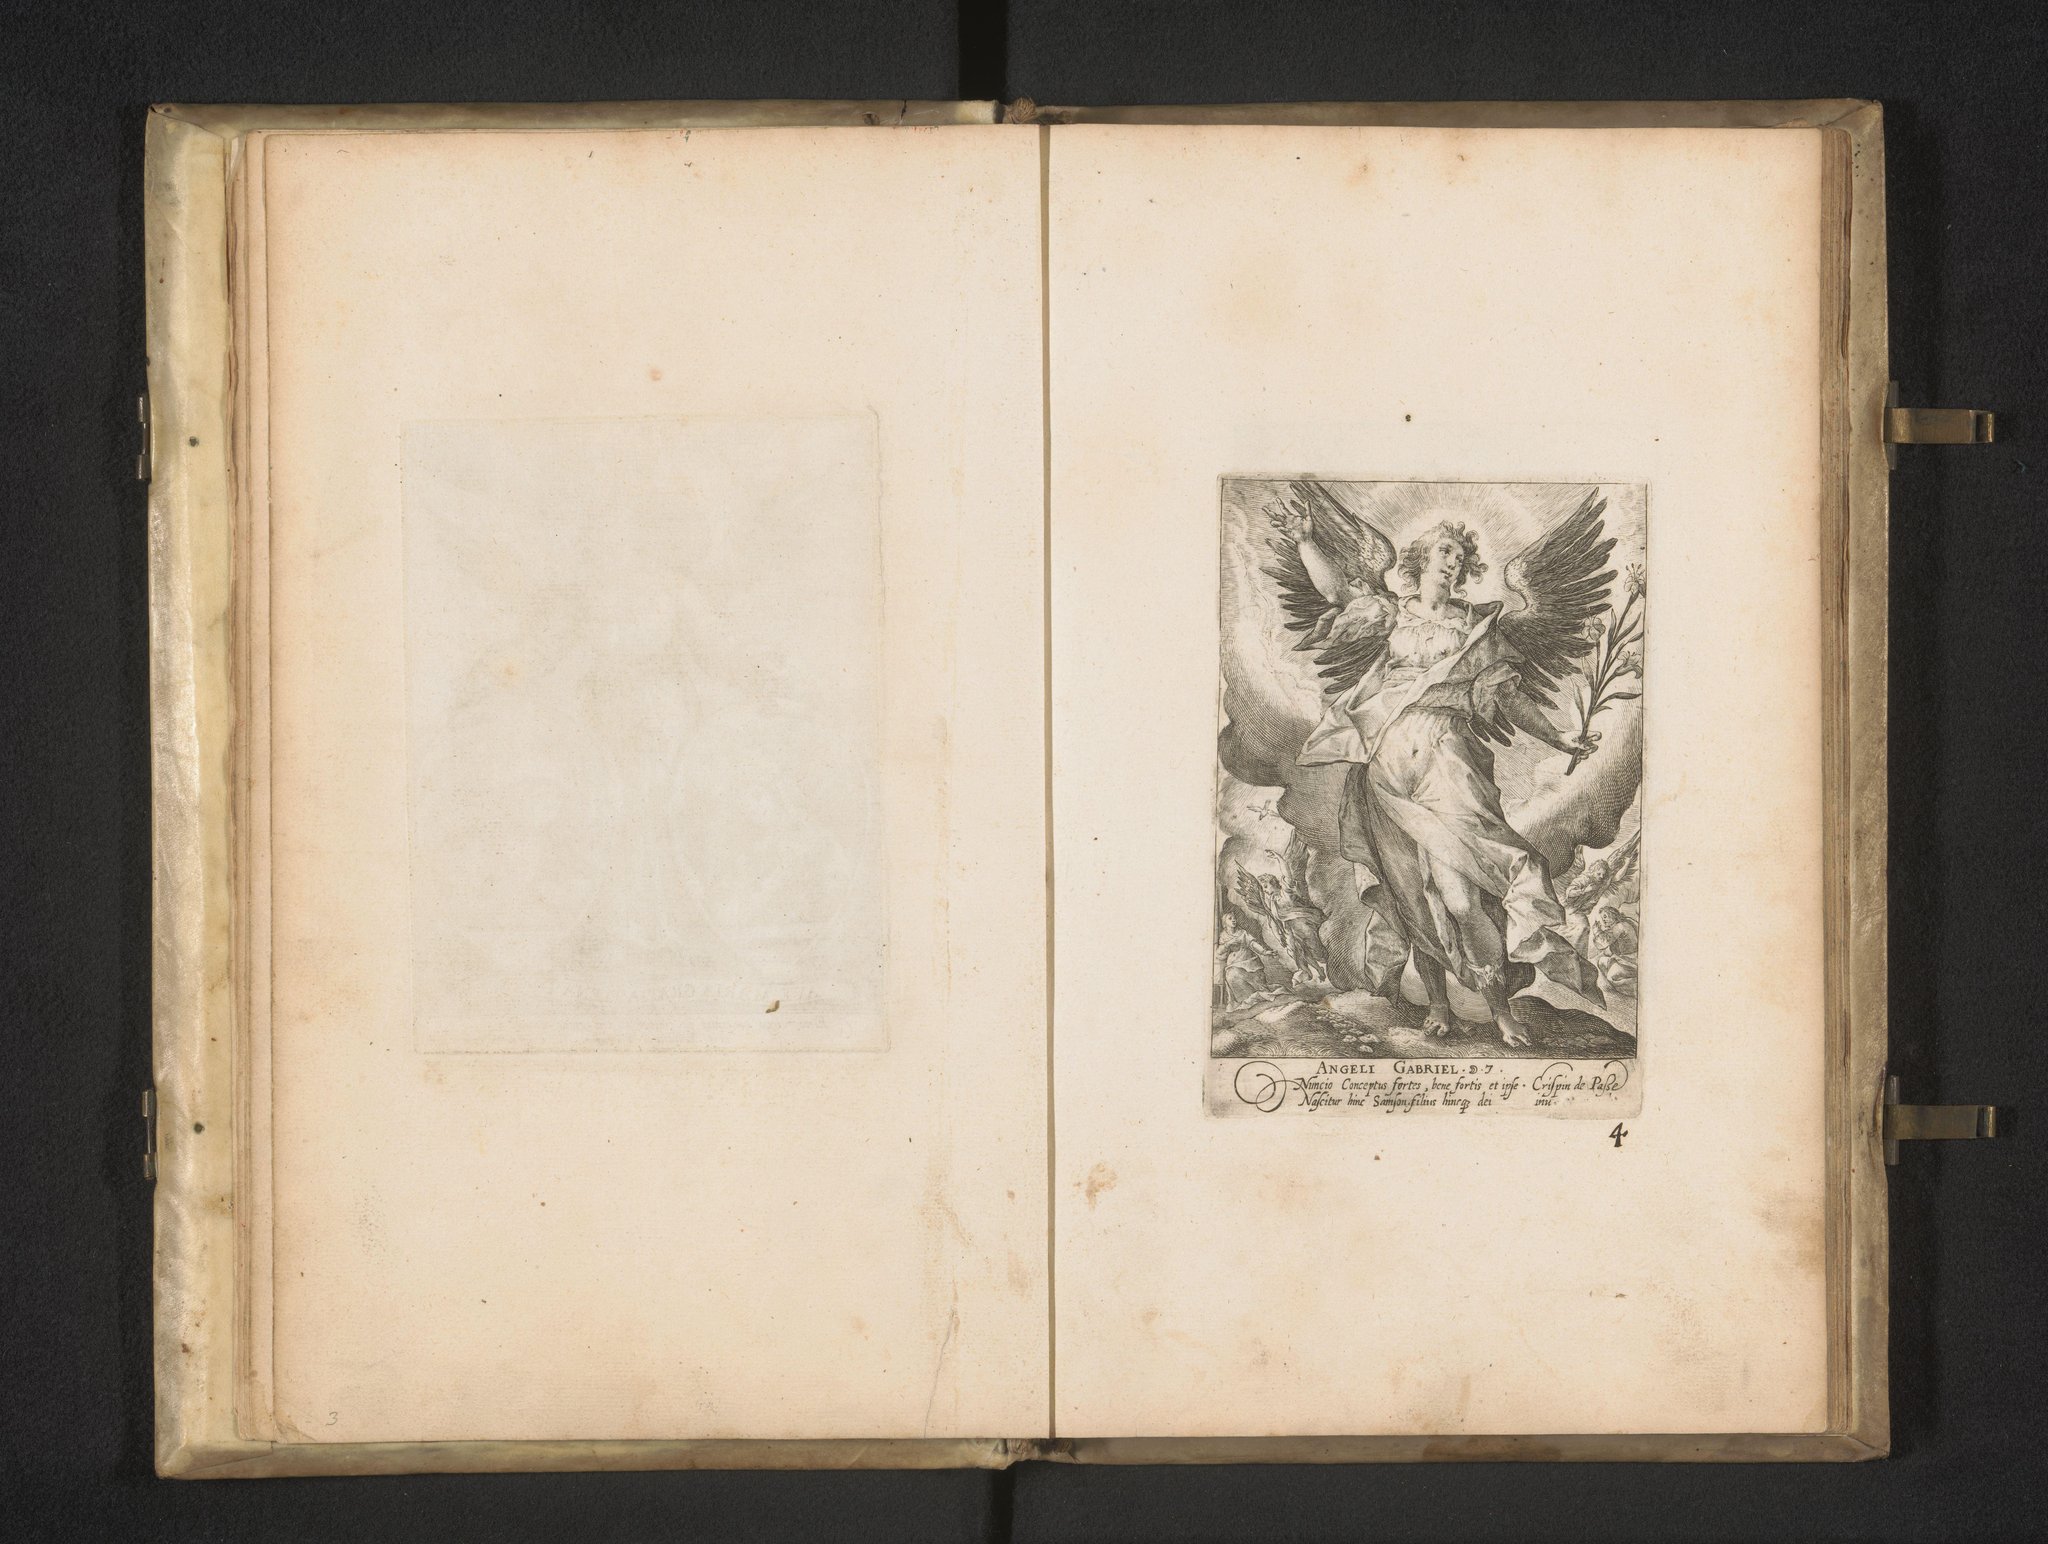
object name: print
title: Aartsengelen en andere engelen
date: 1585-1637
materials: paper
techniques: engraving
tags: the archangel gabriel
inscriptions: number: ‘4’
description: Aartsengel Gabriël. Genummerd in het onderschrift: 7. Maakt in dit album deel uit van een serie van twaalf voorstellingen van aartsengelen en andere engelen. Onderdeel van een album met voornamelijk christelijke voorstellingen.